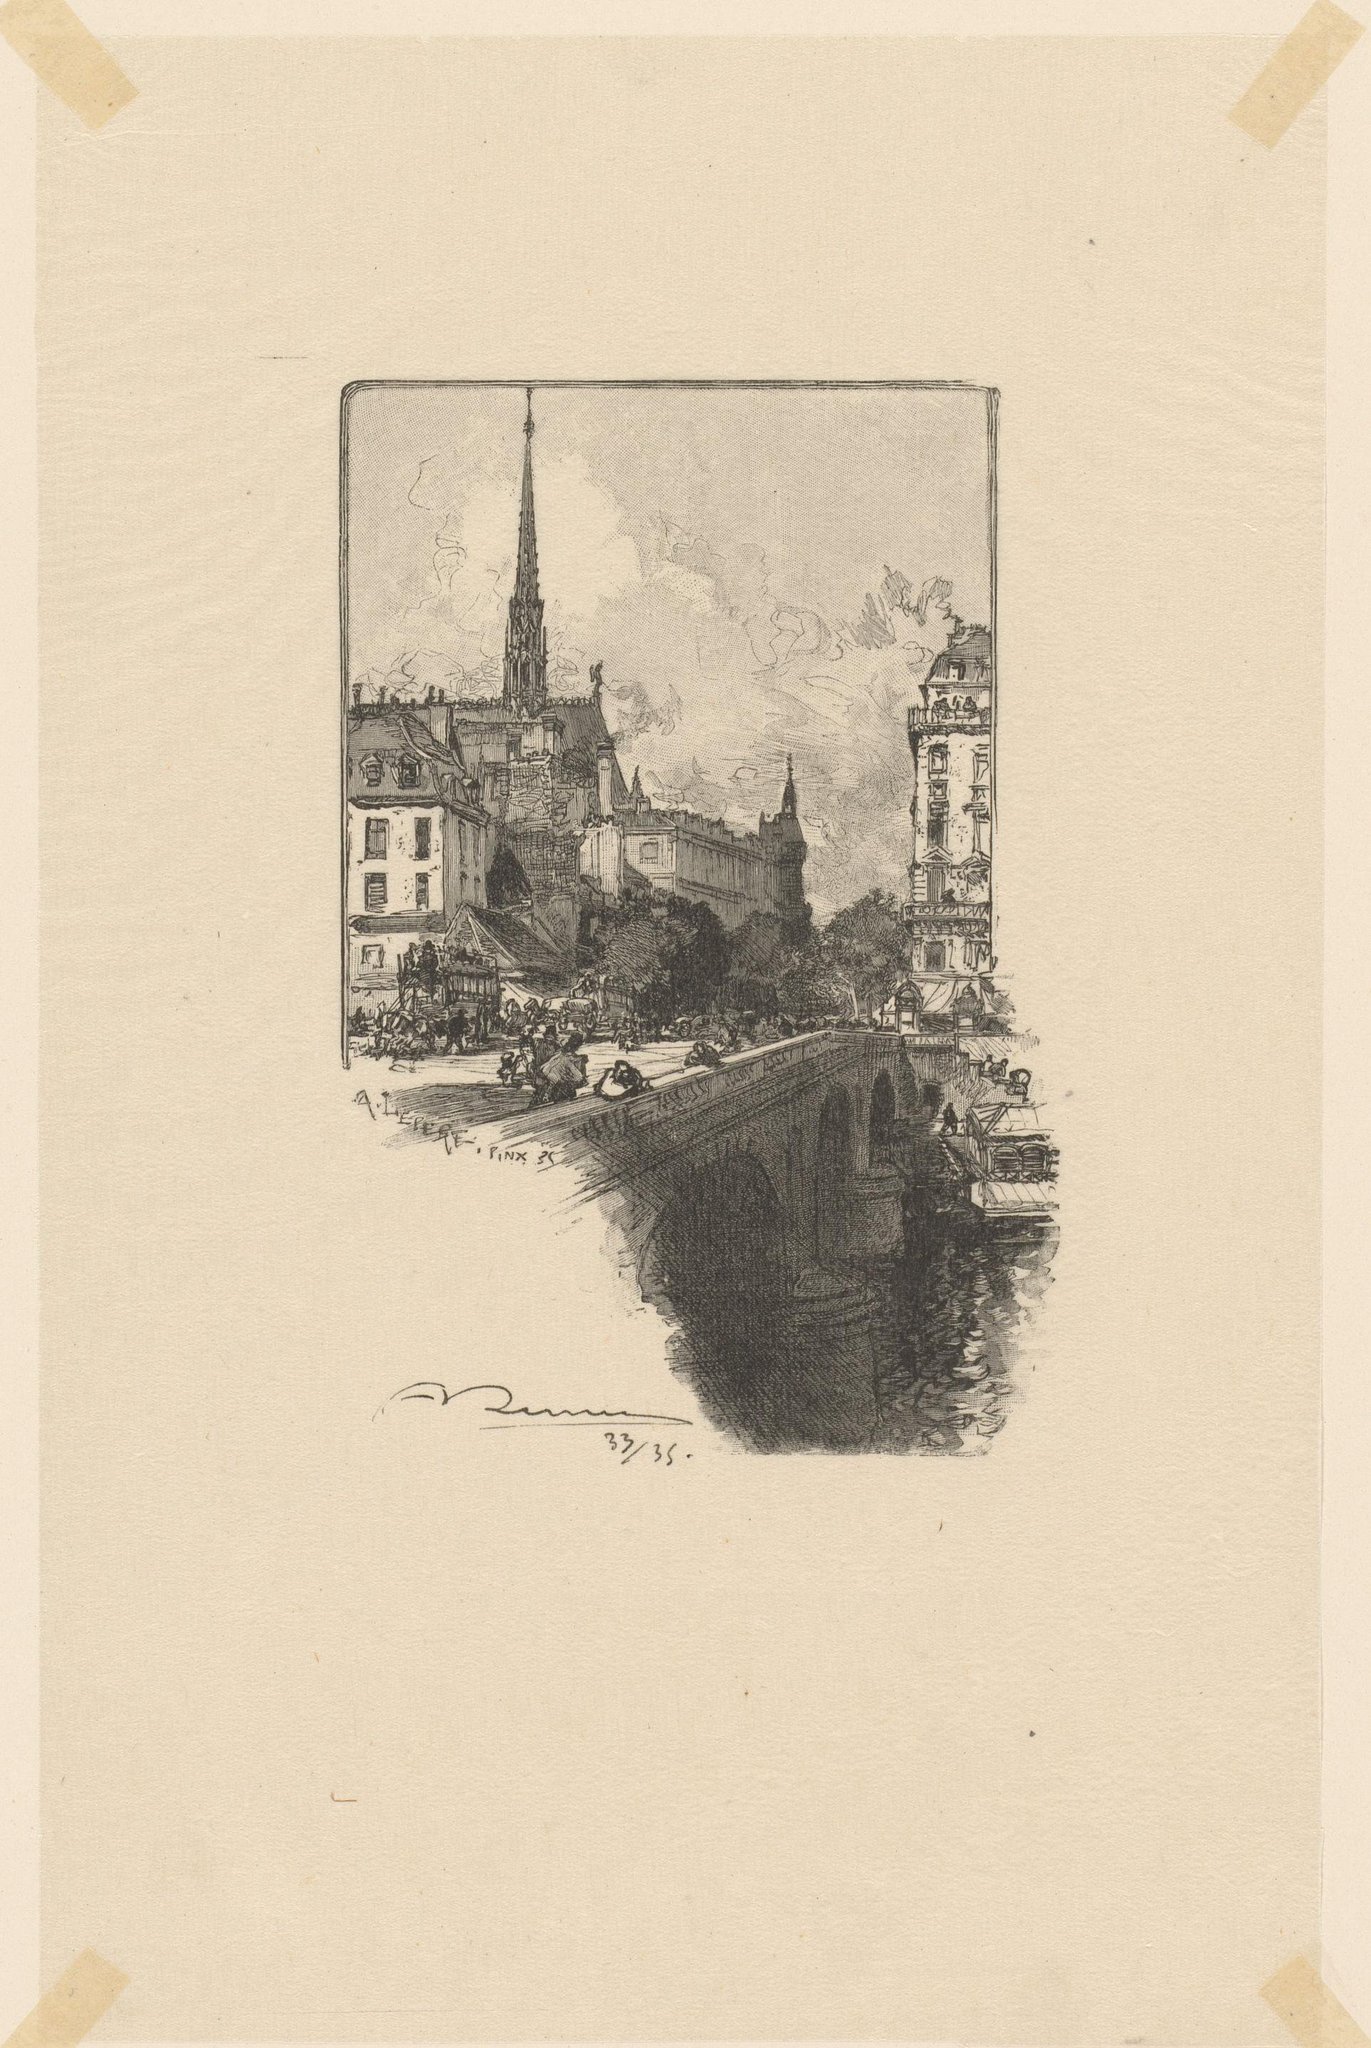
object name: print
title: L'Oeuvre gravé sur bois de Auguste Lepère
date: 1910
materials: paper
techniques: engraving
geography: paris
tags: bridge in city across river, canal, etc., prospect of city, town panorama, silhouette of city, paris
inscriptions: collector's mark: Lugt 2228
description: Deze serie heeft als titel 'Le long de la Seine et des boulevards'. Deze serie is het vierde deel van het grotere geheel 'L'Oeuvre gravé sur bois de Auguste Lepère'.